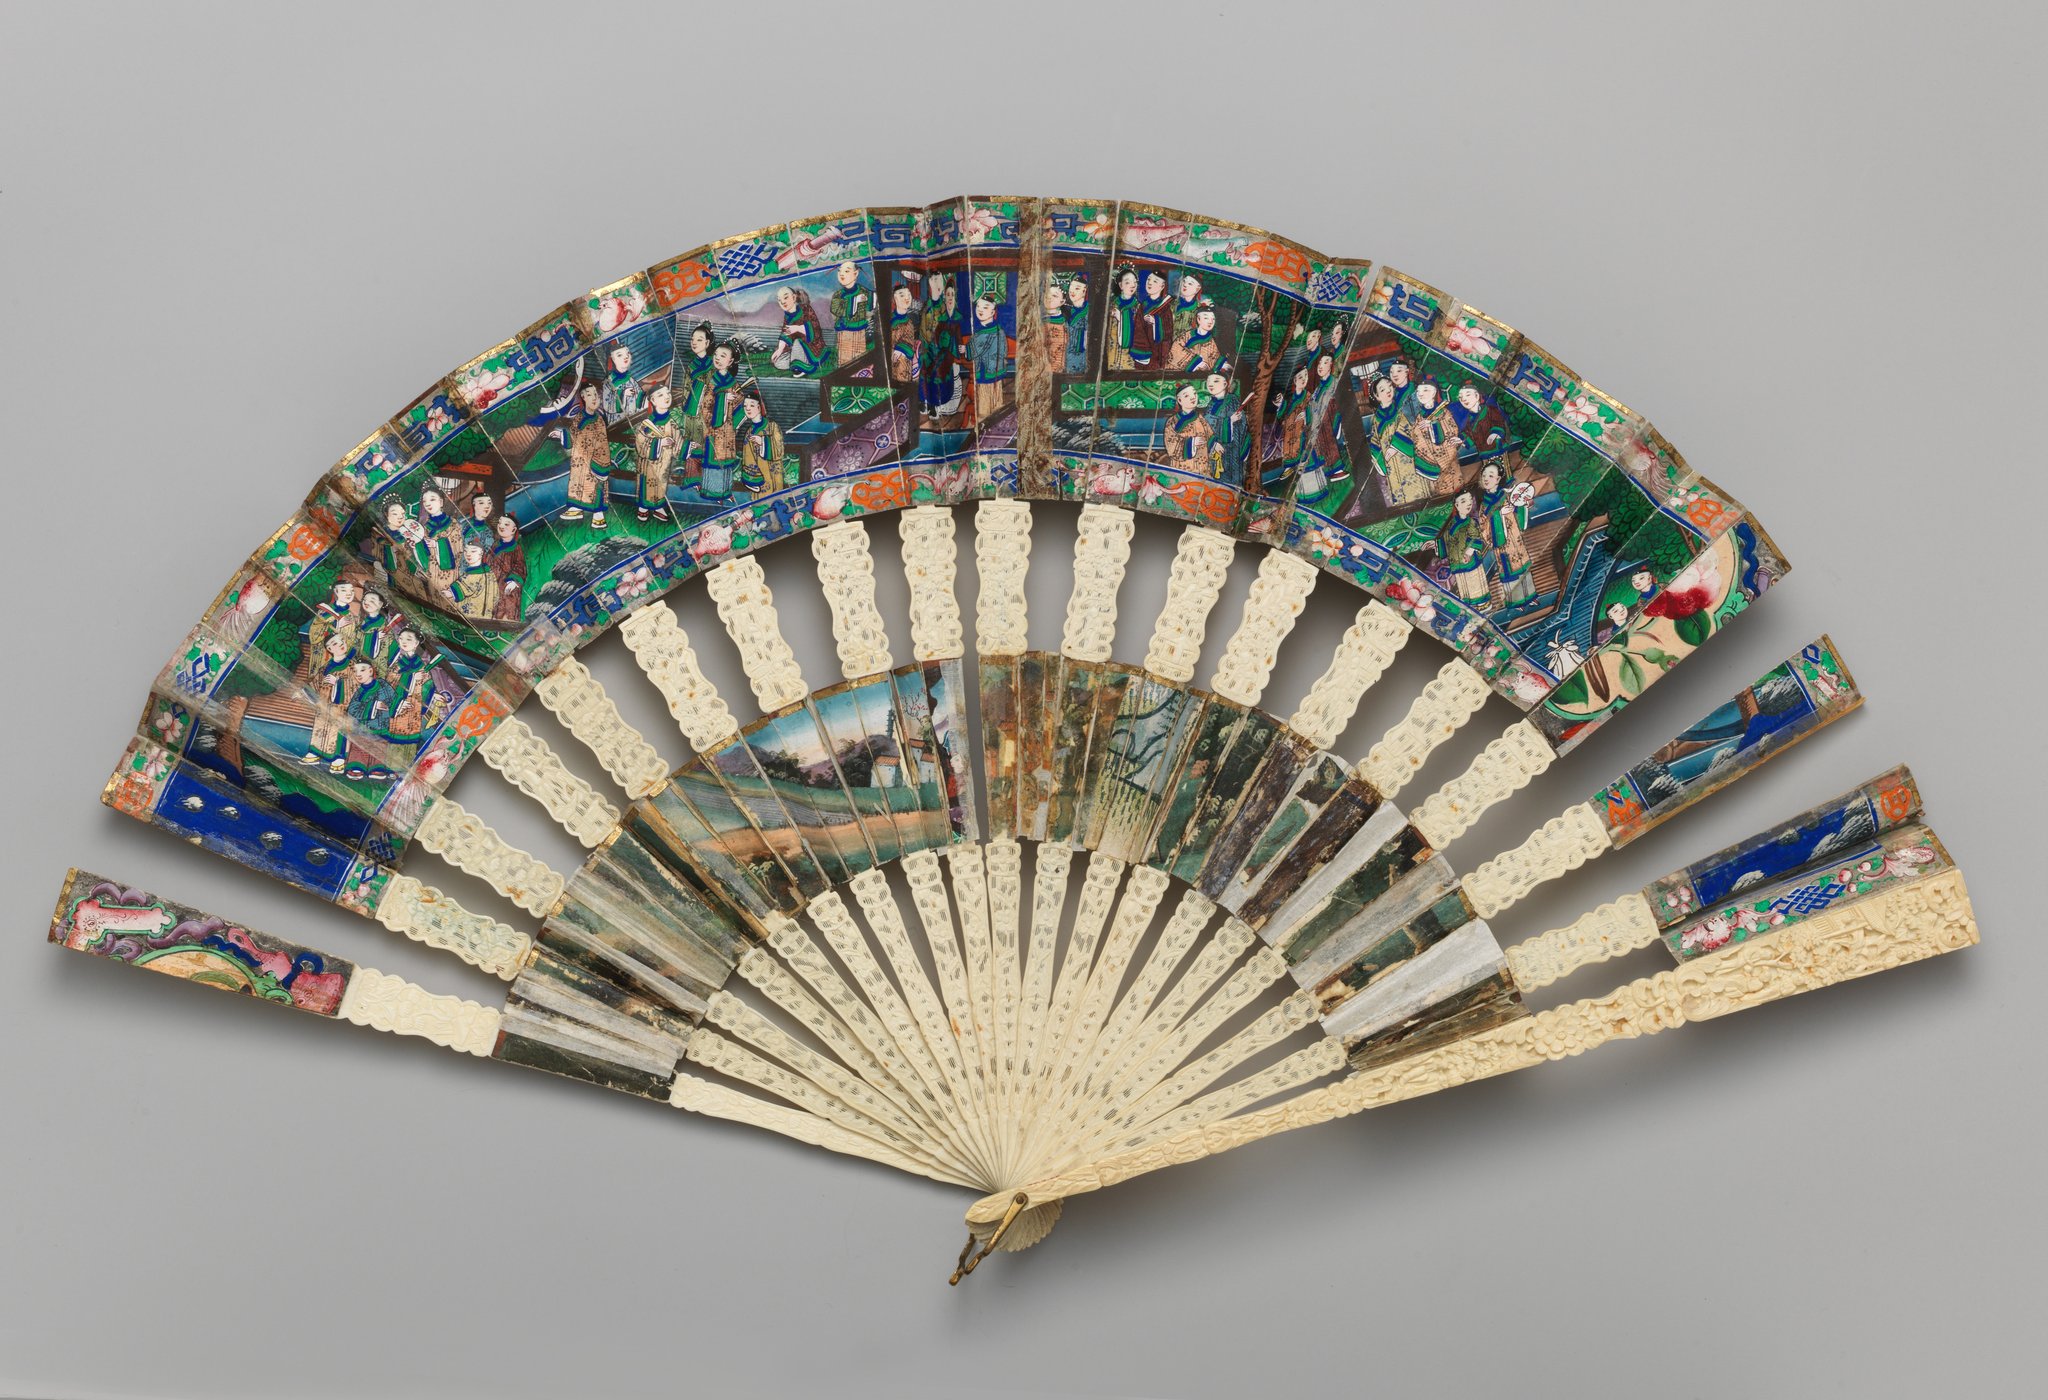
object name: fan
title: Folding Cabriolet Fan with Scene of Figures in a Courtyard Garden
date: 1767-1833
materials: ivory, paper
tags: men,women